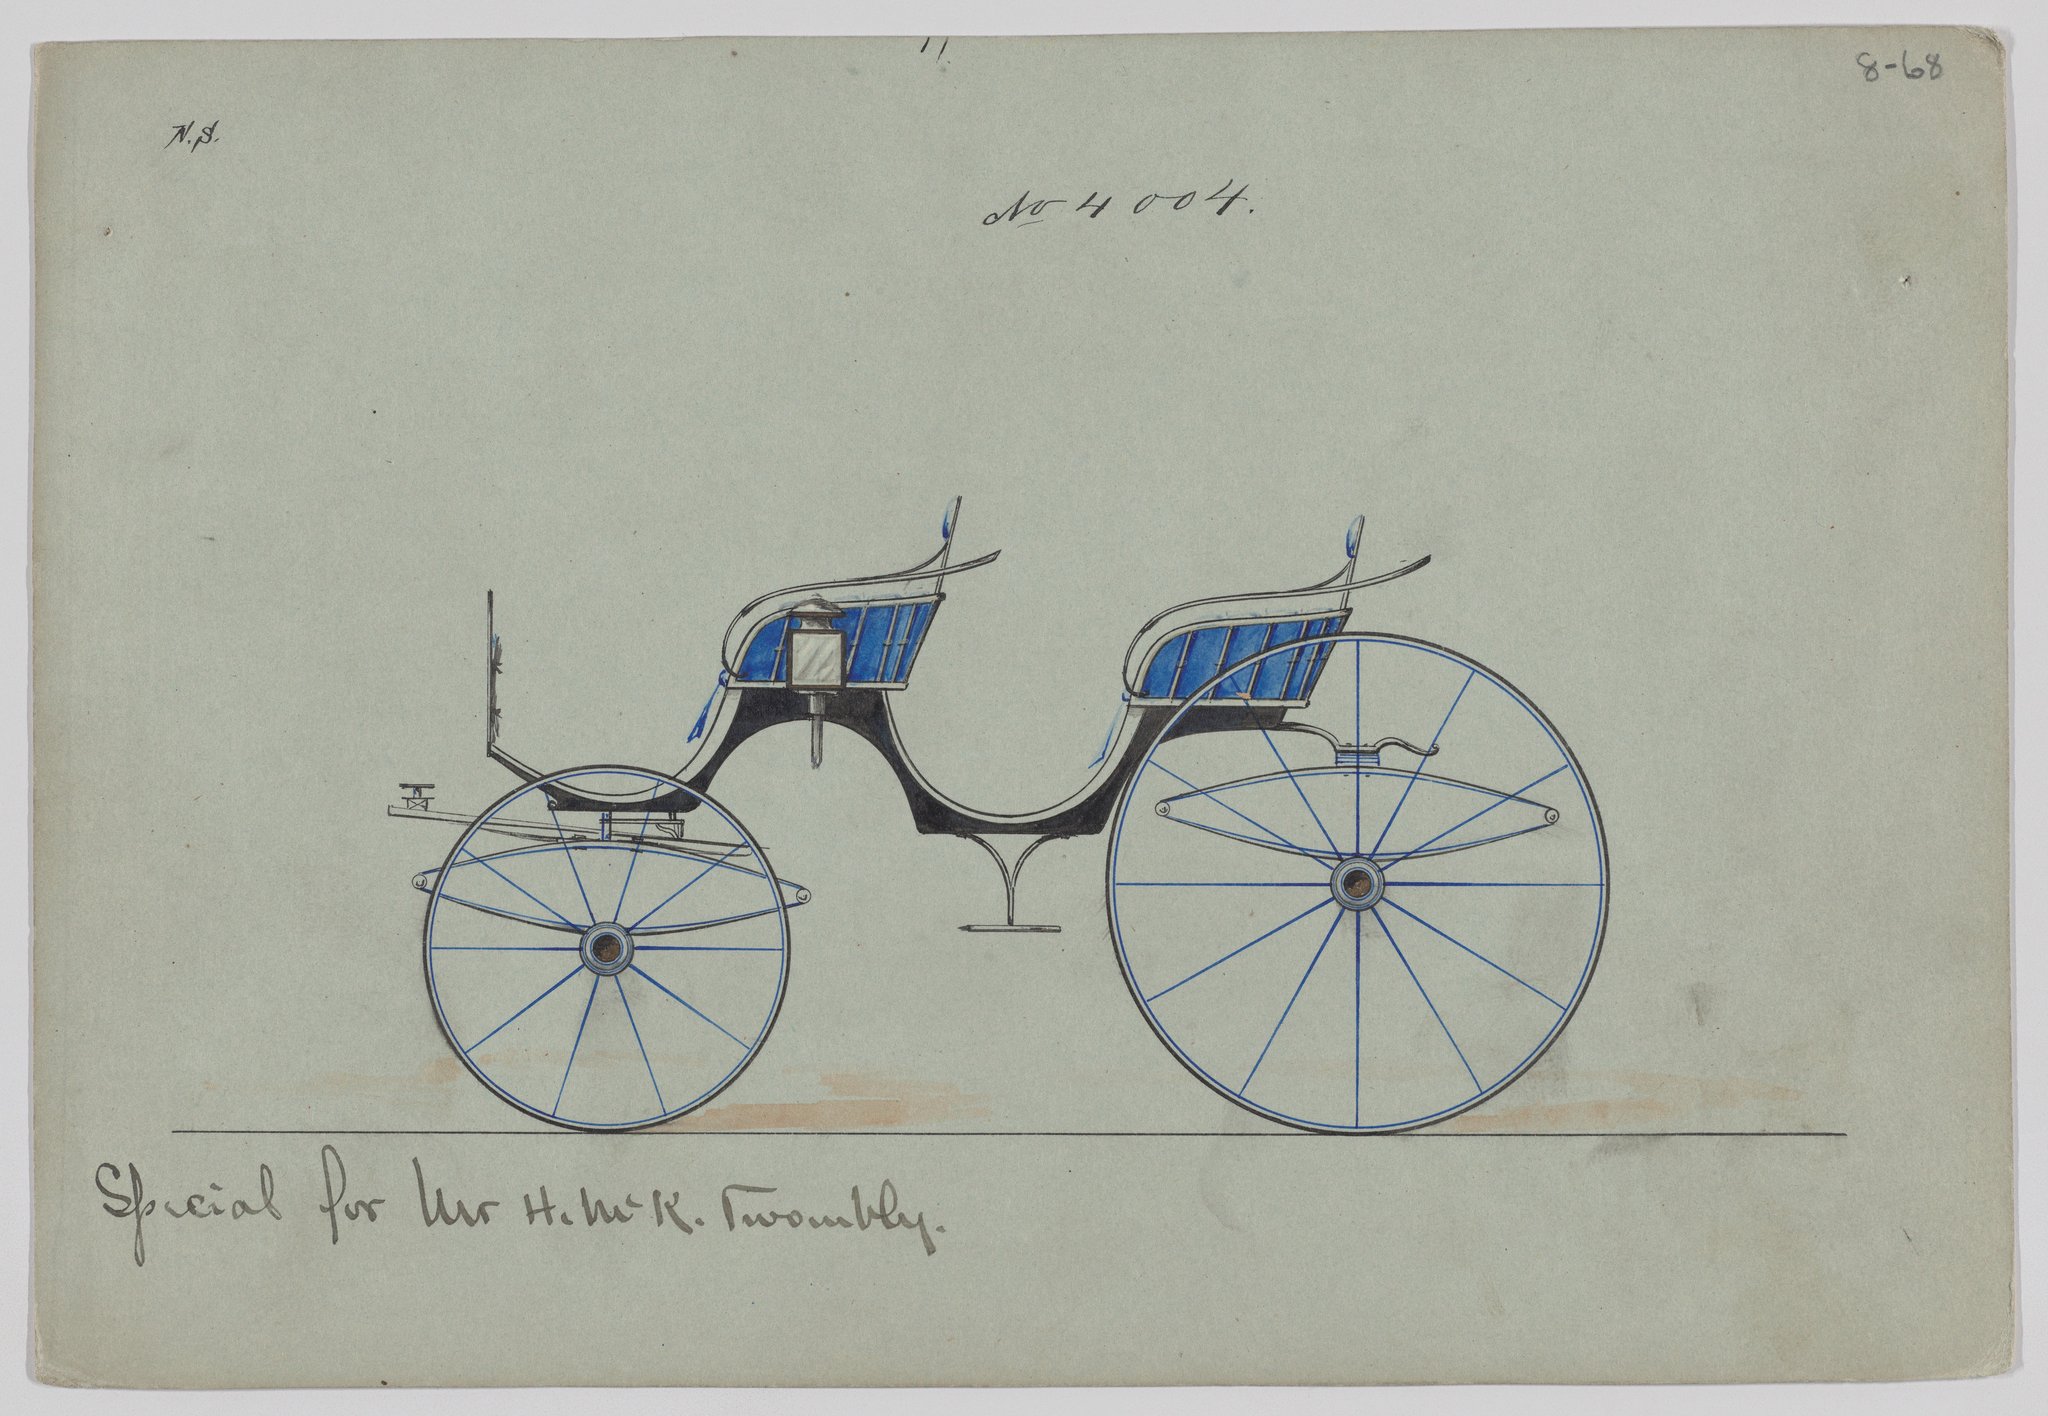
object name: drawing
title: Design for 4 seat Phaeton, no top, no. 4004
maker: brewster & co.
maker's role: manufacturer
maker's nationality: american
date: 1887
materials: gouache, ink, watercolor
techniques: pen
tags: carriages